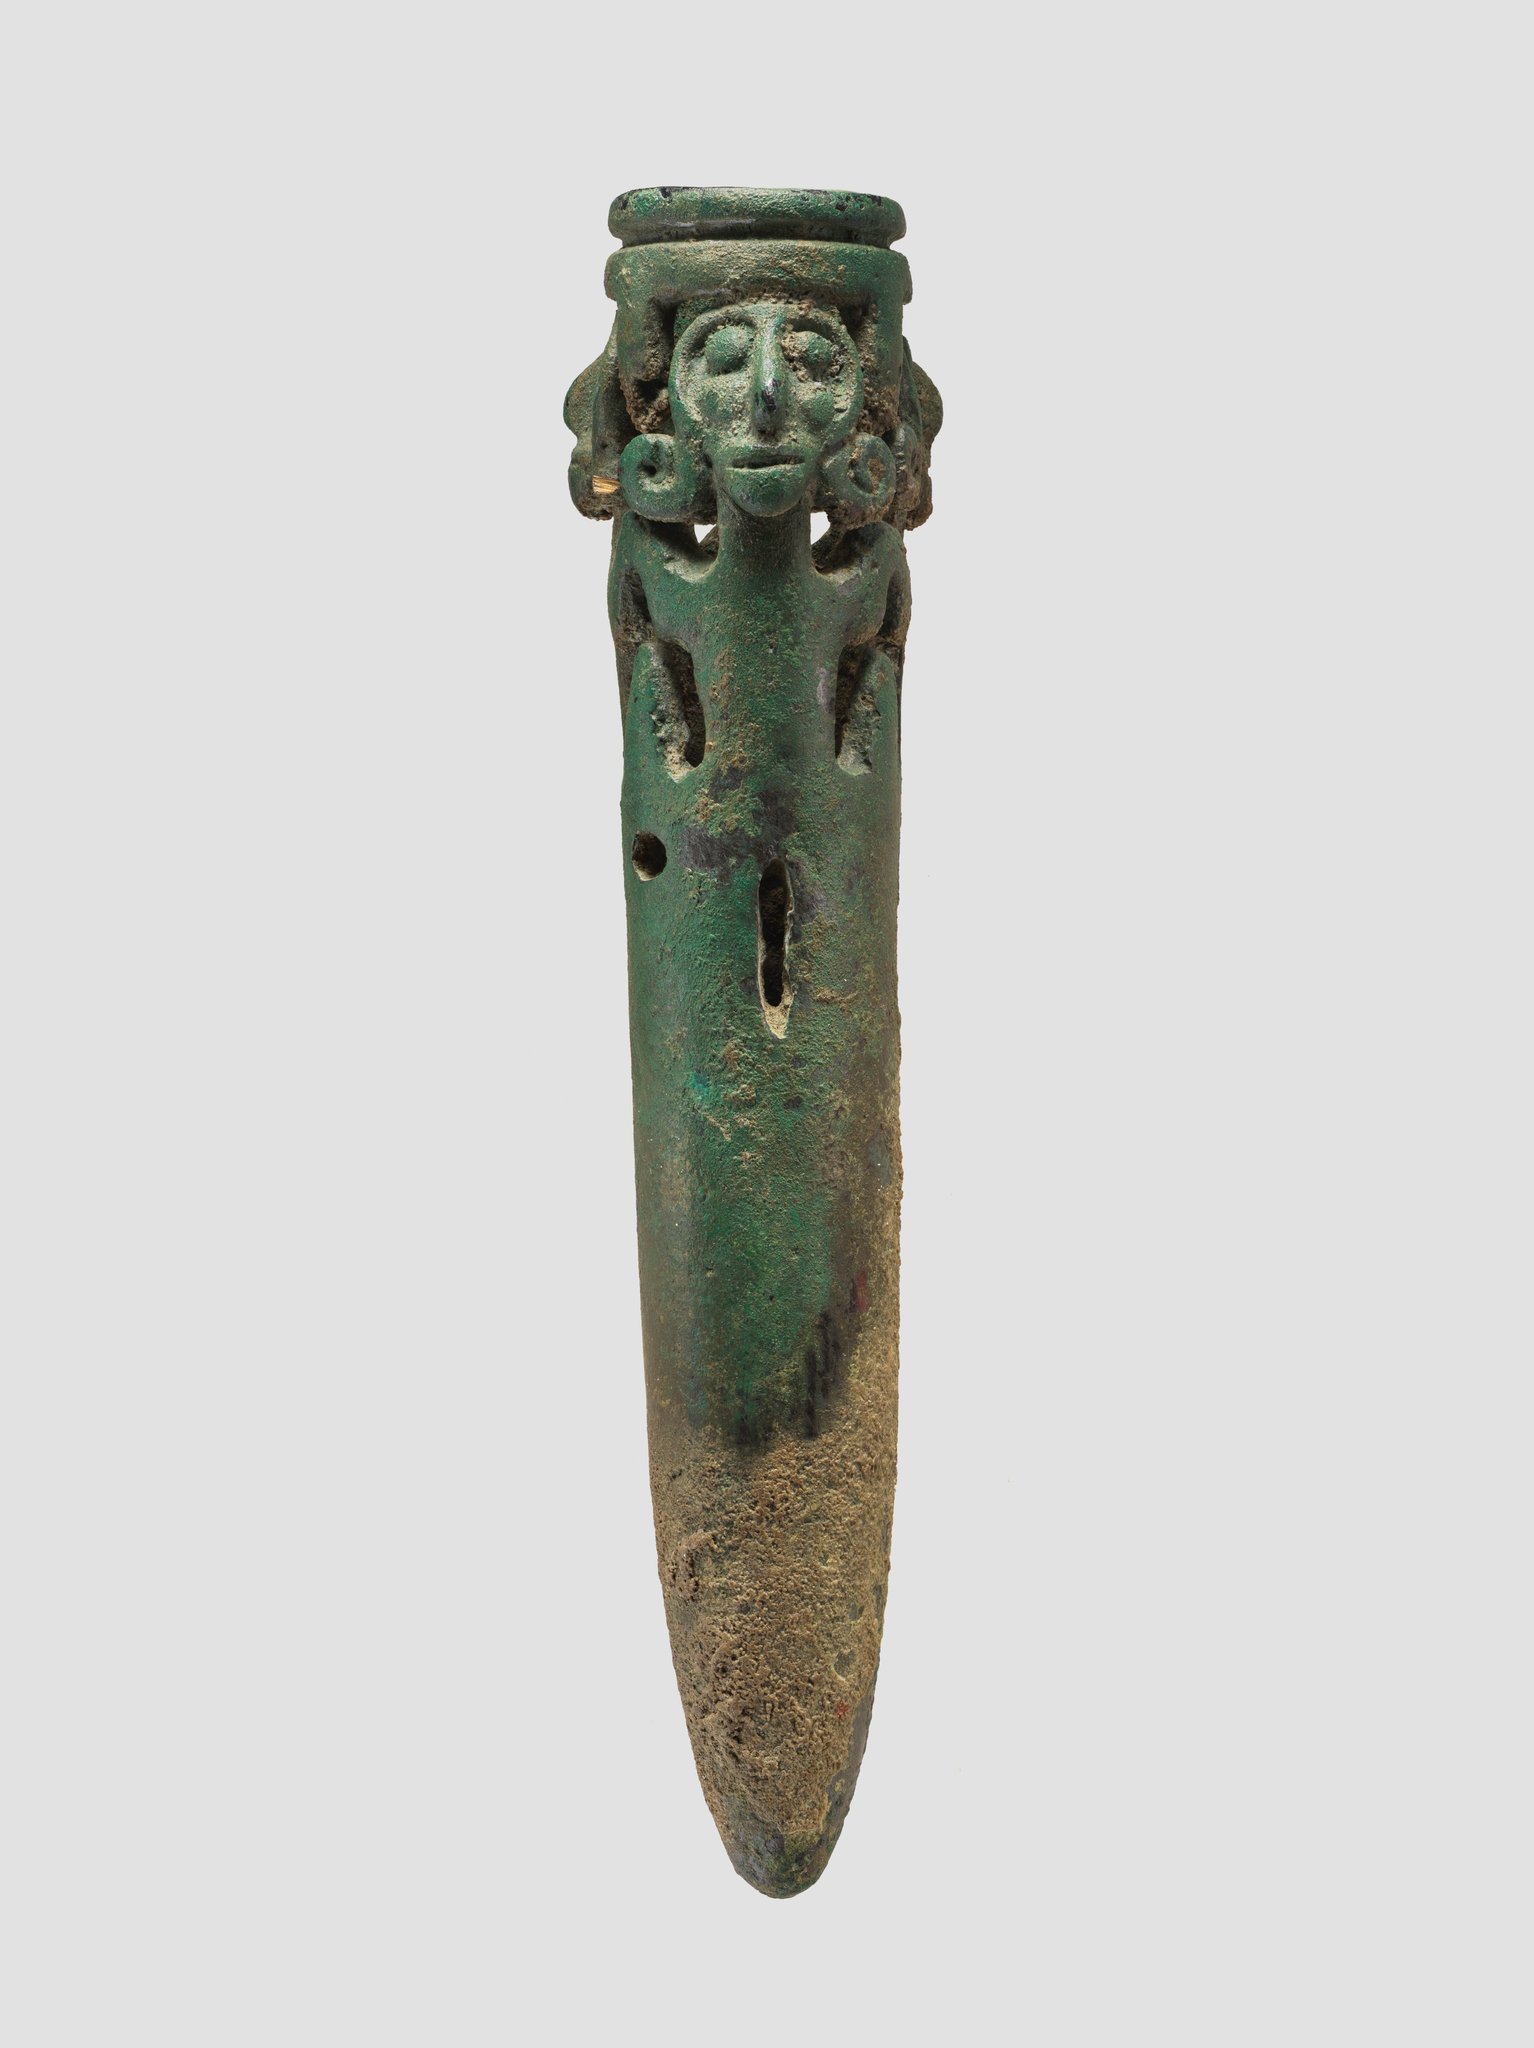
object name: peg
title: Peg (?)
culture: iranian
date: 1000-1 BCE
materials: bronze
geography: iran, probably from luristan